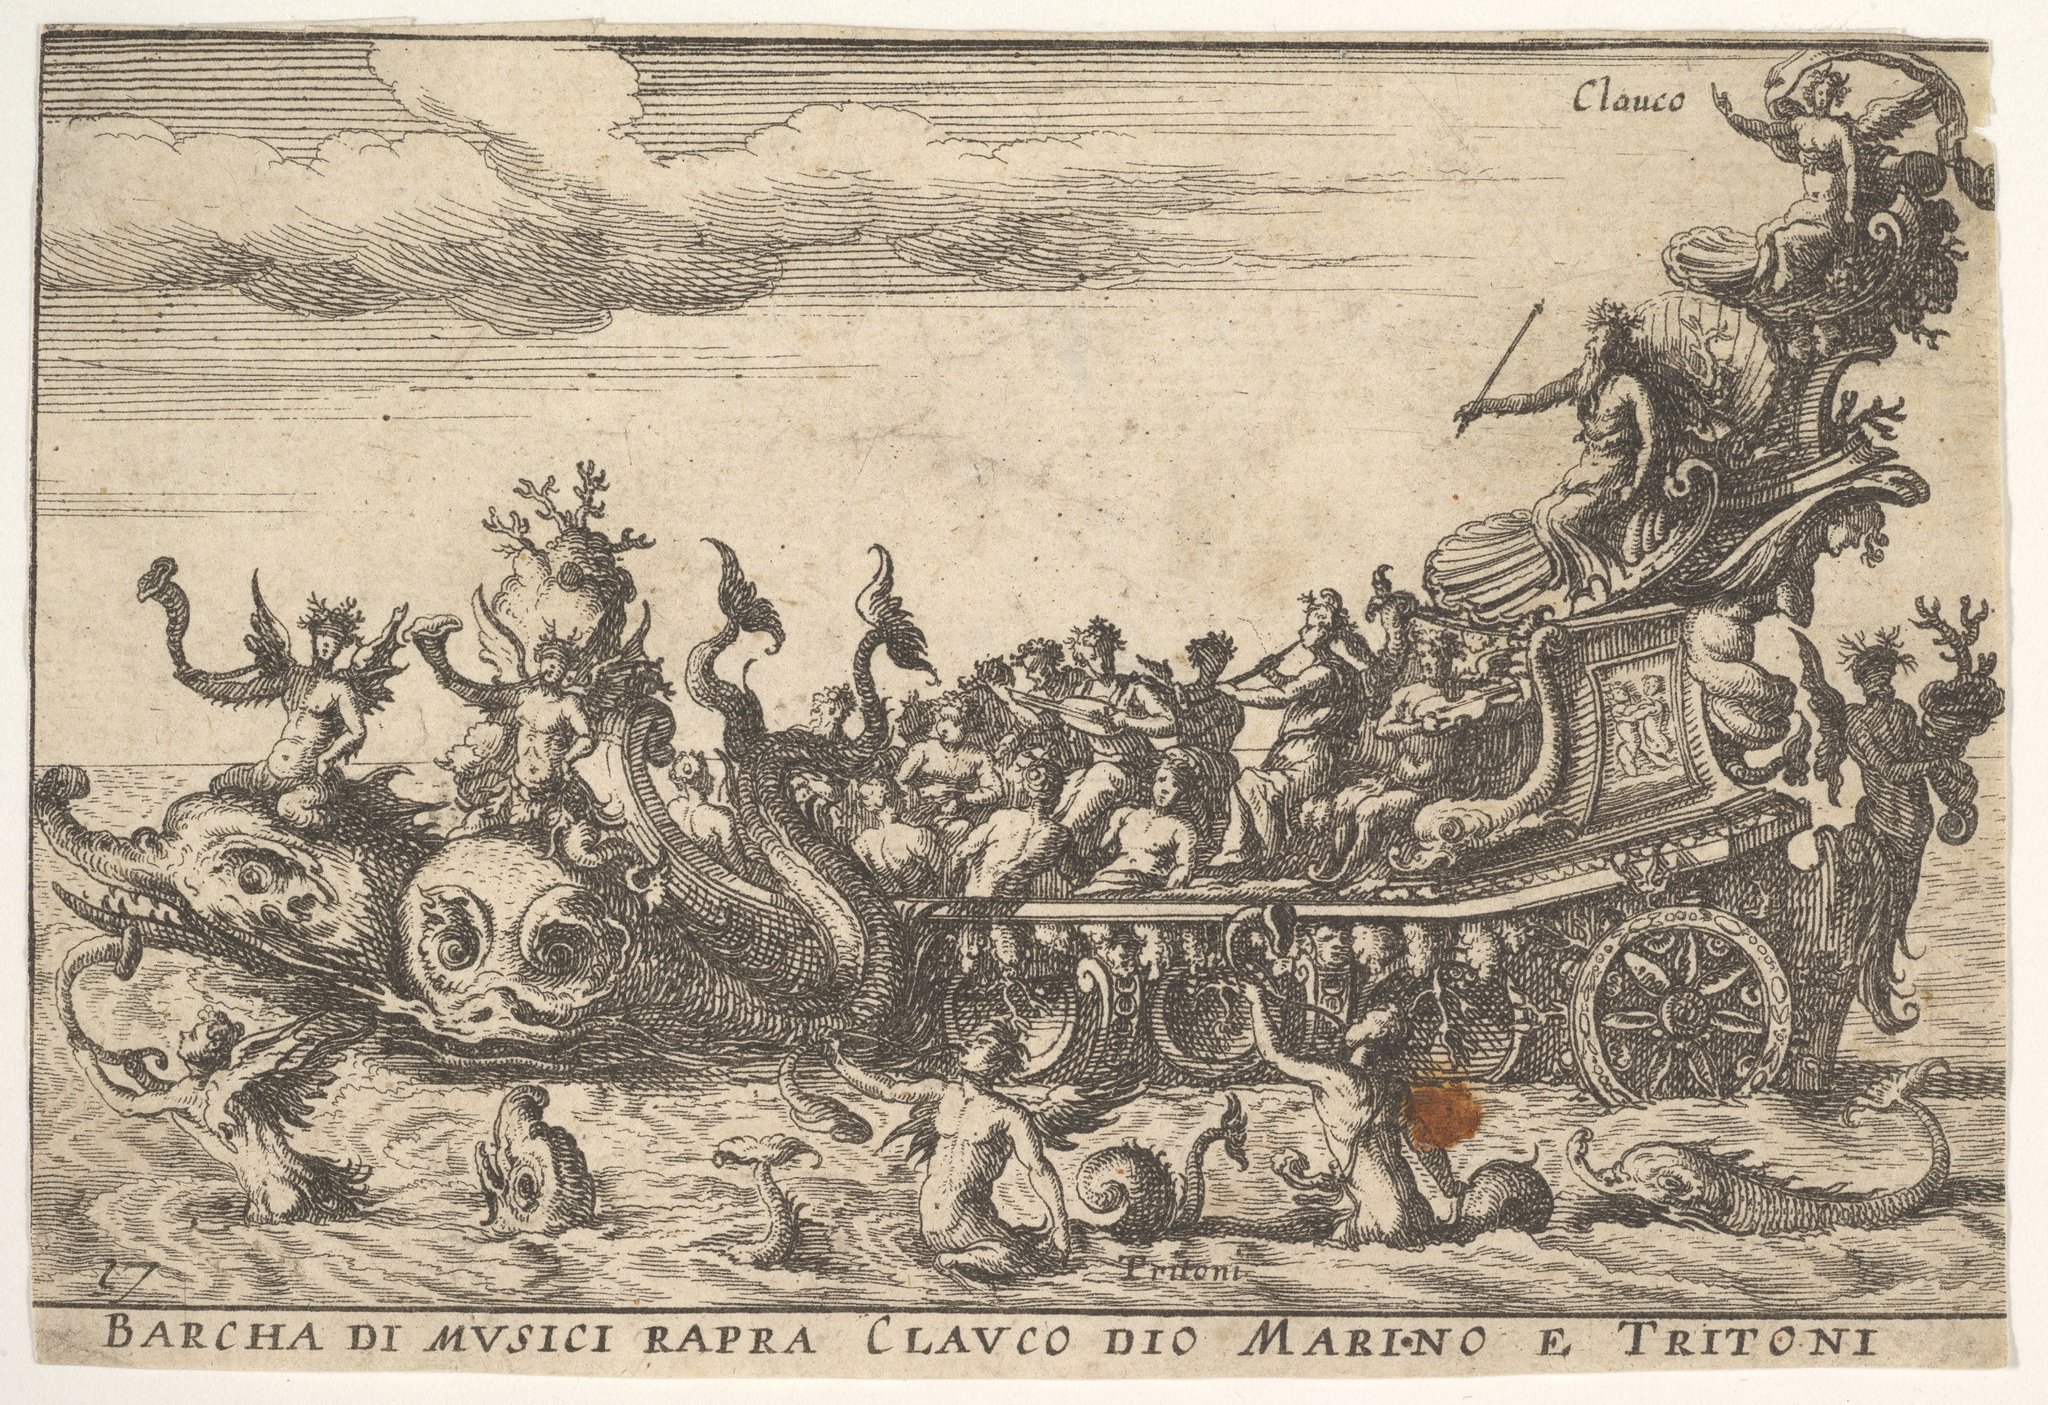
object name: print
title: Plate 16: Ship of musicians with the sea god Claucus and tritons (Barcha di musici rapra Clauco dio marino e Tritoni), from "The magnificent pageant on the river Arno in Florence for the marriage of the Grand Duke" (Le Magnifique carousel fait sur le fleuve de l'Arne a Florence, pour le mariage du Grand Duc)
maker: Anonymous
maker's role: artist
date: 1664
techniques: etching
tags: triton,musicians,ships